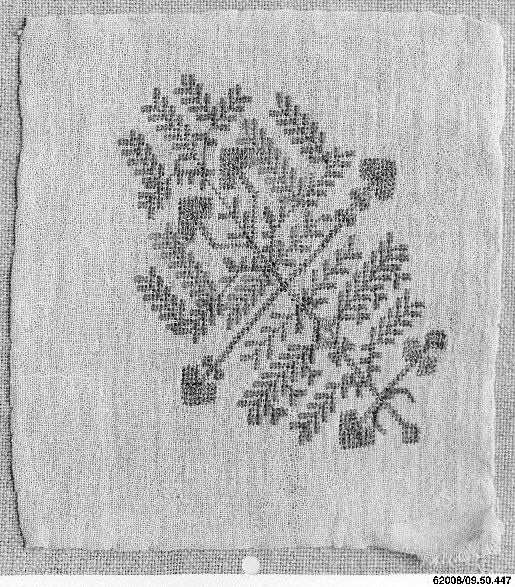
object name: textile fragment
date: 1701-1900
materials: linen, metal thread, silk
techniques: embroidery, weave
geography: syria